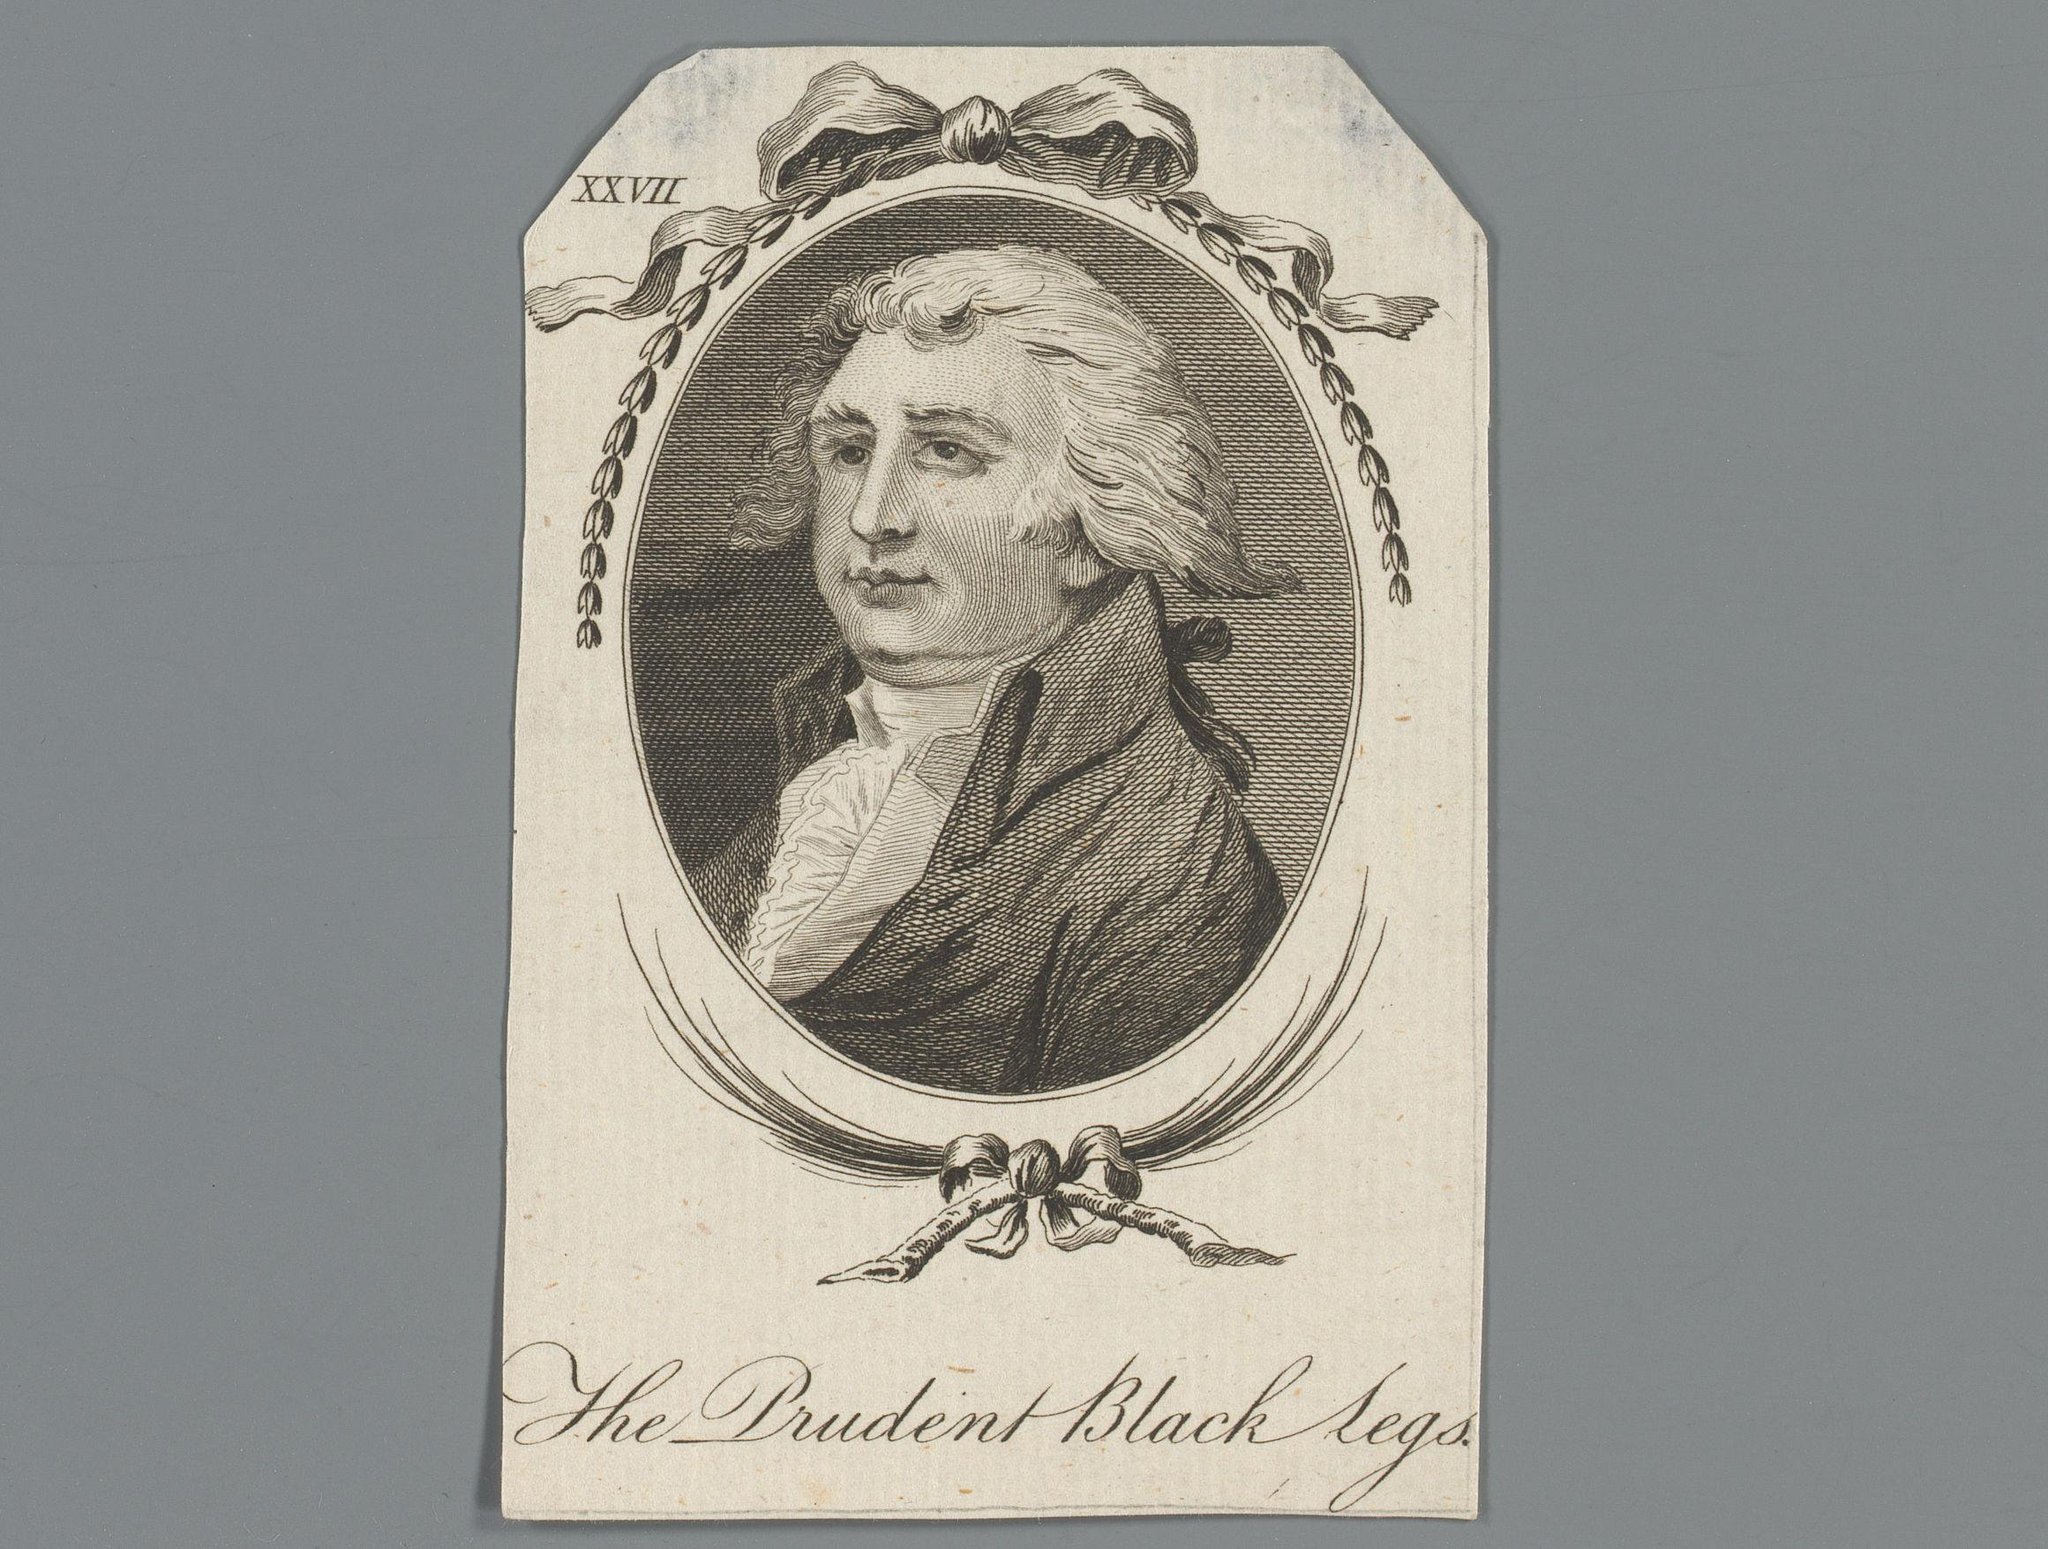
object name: print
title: Portret van een onbekende man met een pruik als "The Prudent Black Legs"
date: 1769-1796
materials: paper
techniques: engraving, etching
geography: london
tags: wig, historical persons not known by name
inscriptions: collector's mark: Lugt 2228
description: Prent waarschijnlijk uit: Town and Country Magazine [1769-1796].